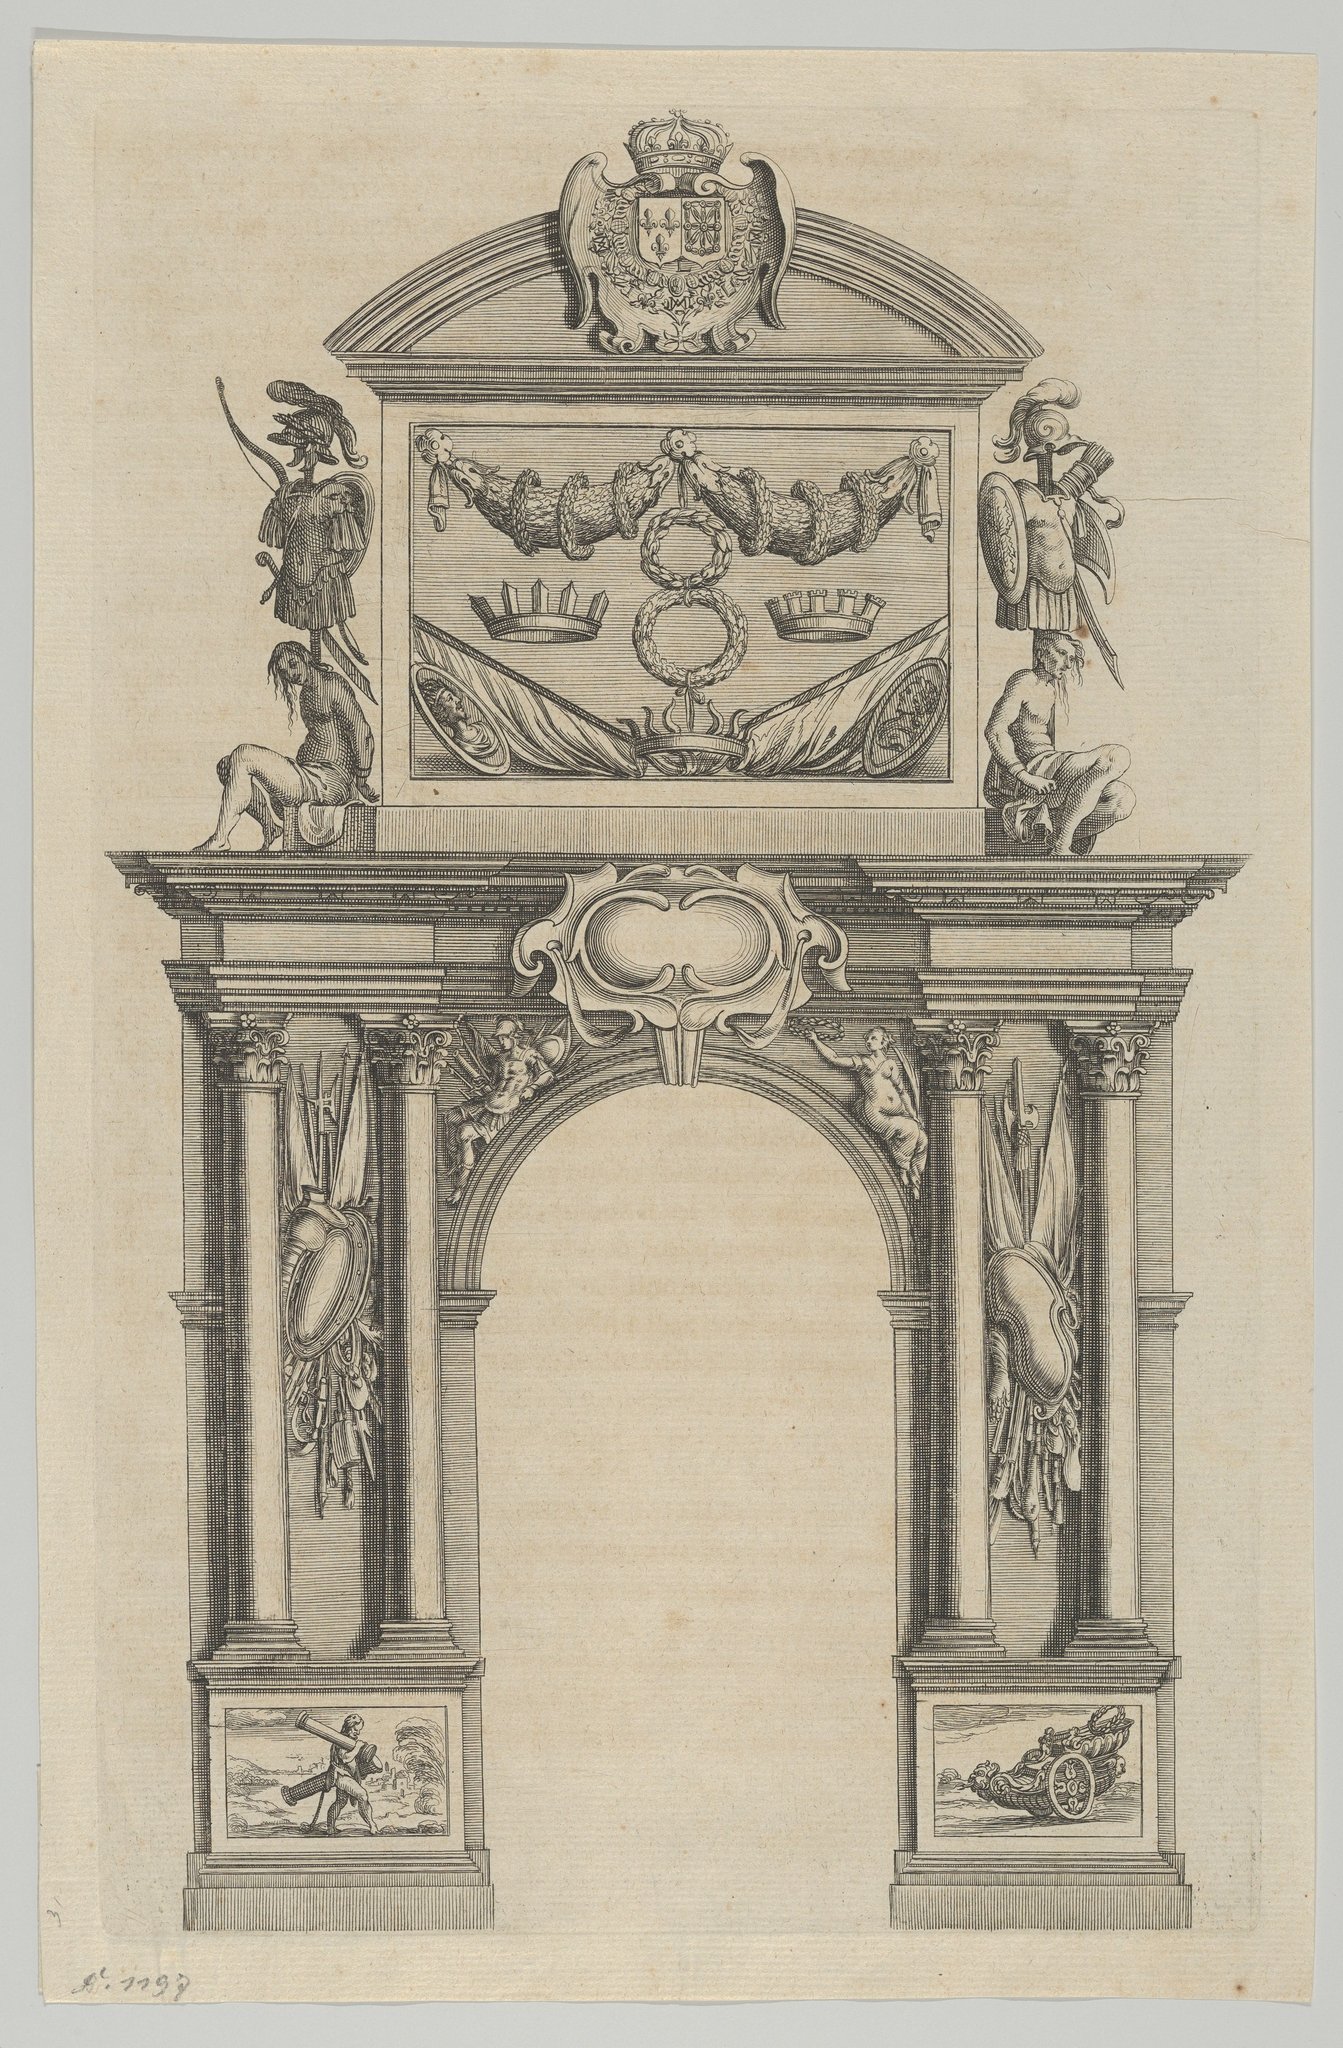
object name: print, fete, ornament architecture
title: Triumphal arch, from 'Éloges et discours sur la triomphante réception du Roy en sa ville de Paris ...' by Jean-Baptiste de Machault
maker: melchior tavernier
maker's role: artist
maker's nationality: french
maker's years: 1564-1641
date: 1629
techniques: etching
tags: arches,coat of arms